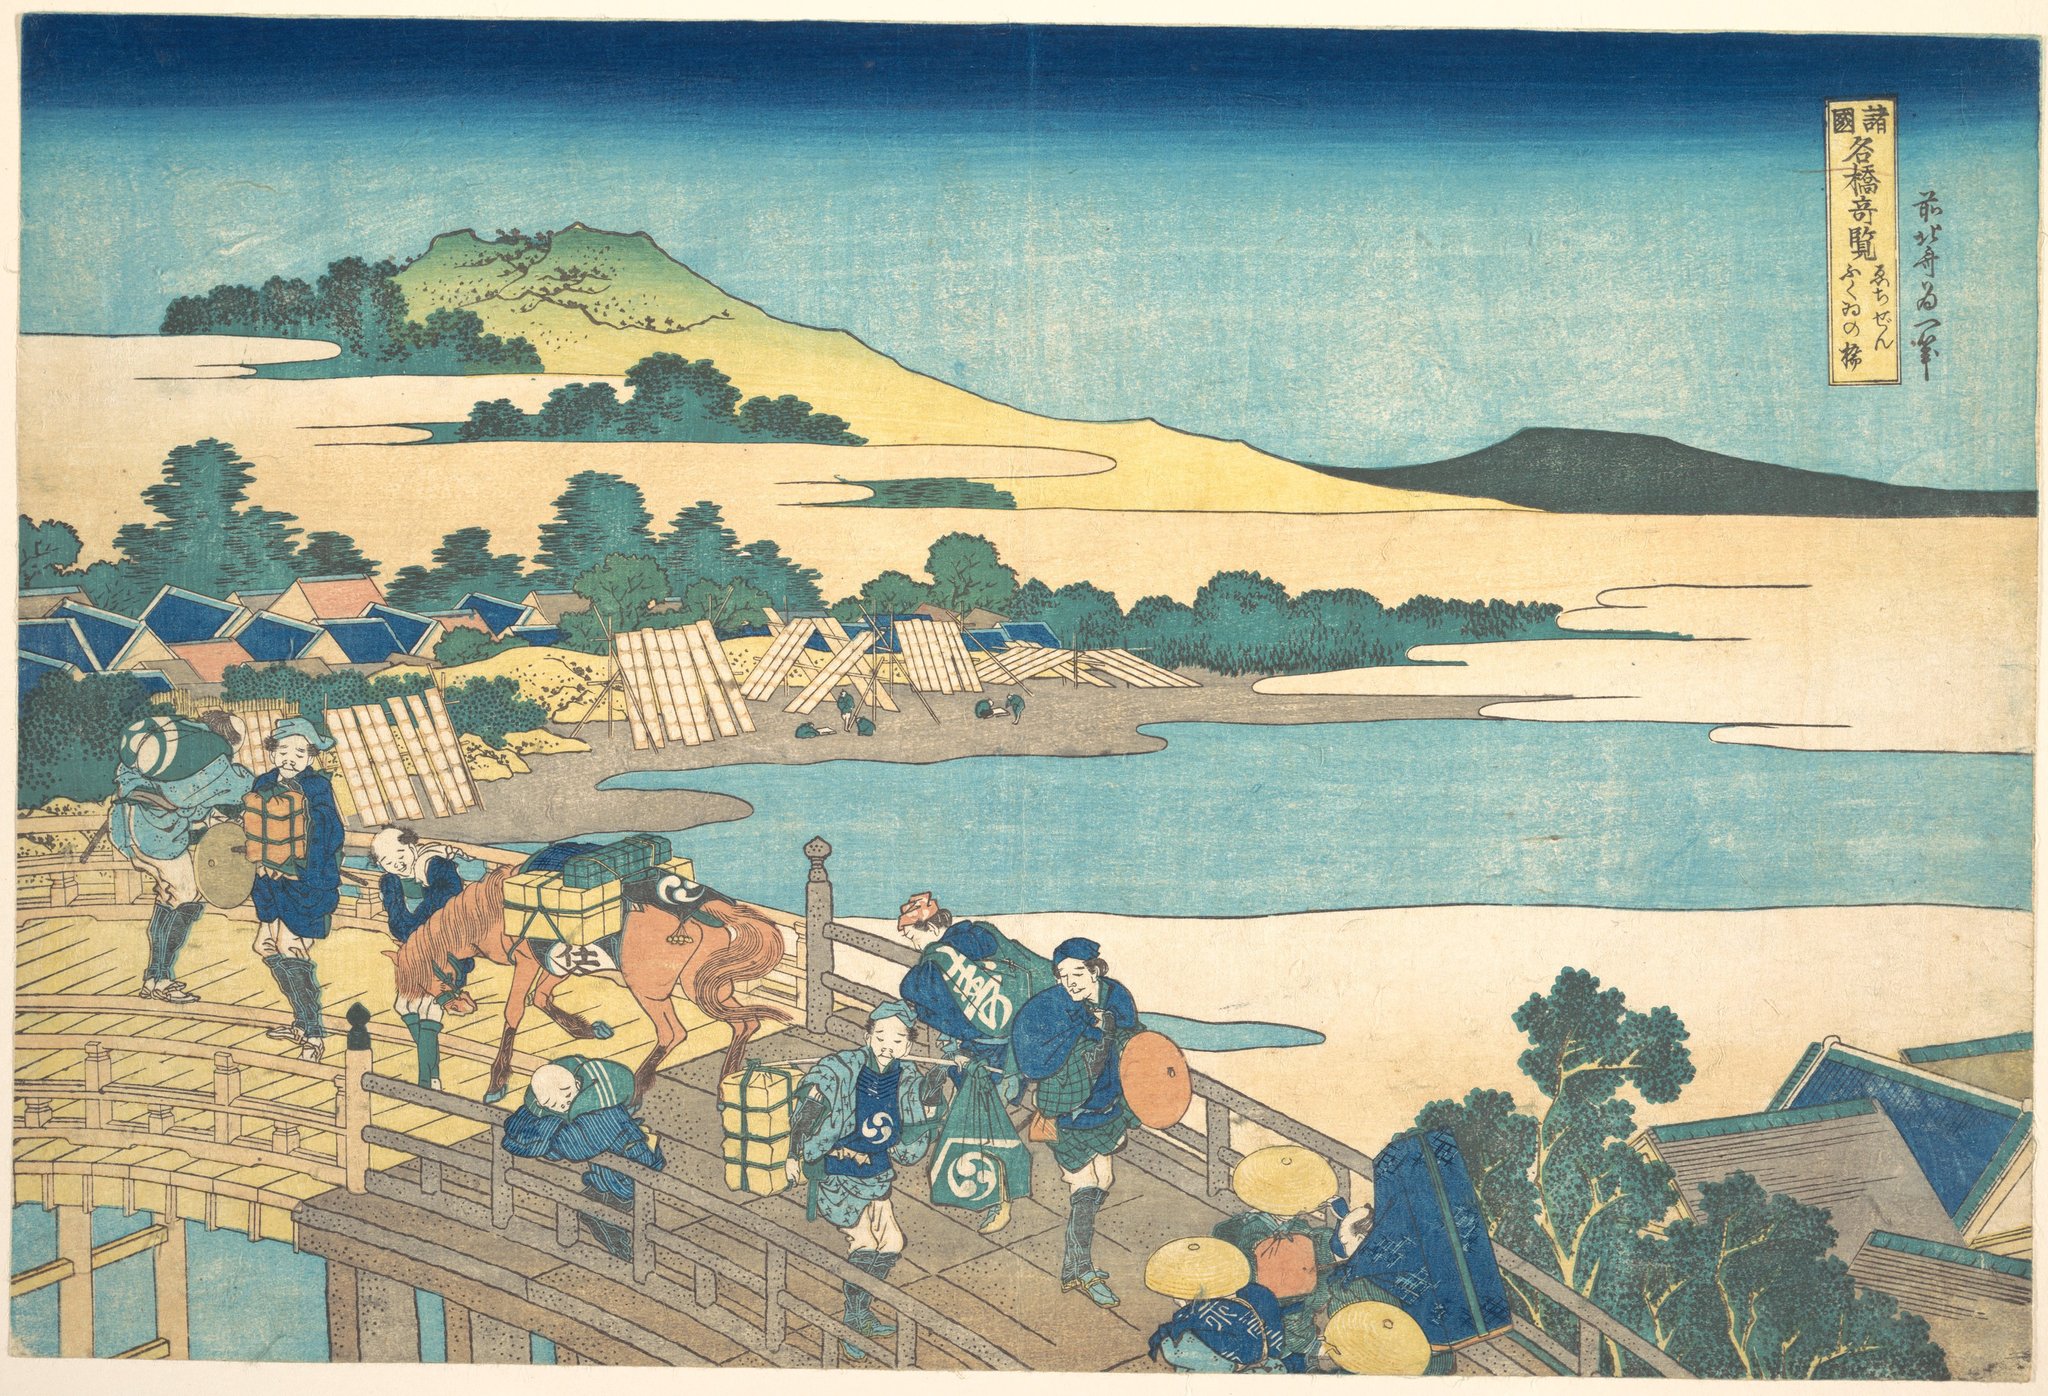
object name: woodblock print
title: Fukui Bridge in Echizen Province (Echizen Fukui no hashi), from the series Remarkable Views of Bridges in Various Provinces (Shokoku meikyō kiran)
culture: japanese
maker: katsushika hokusai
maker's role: artist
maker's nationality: japanese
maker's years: 1760-1849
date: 1830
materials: ink, paper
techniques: woodblock print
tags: bridges,men,horses,landscapes